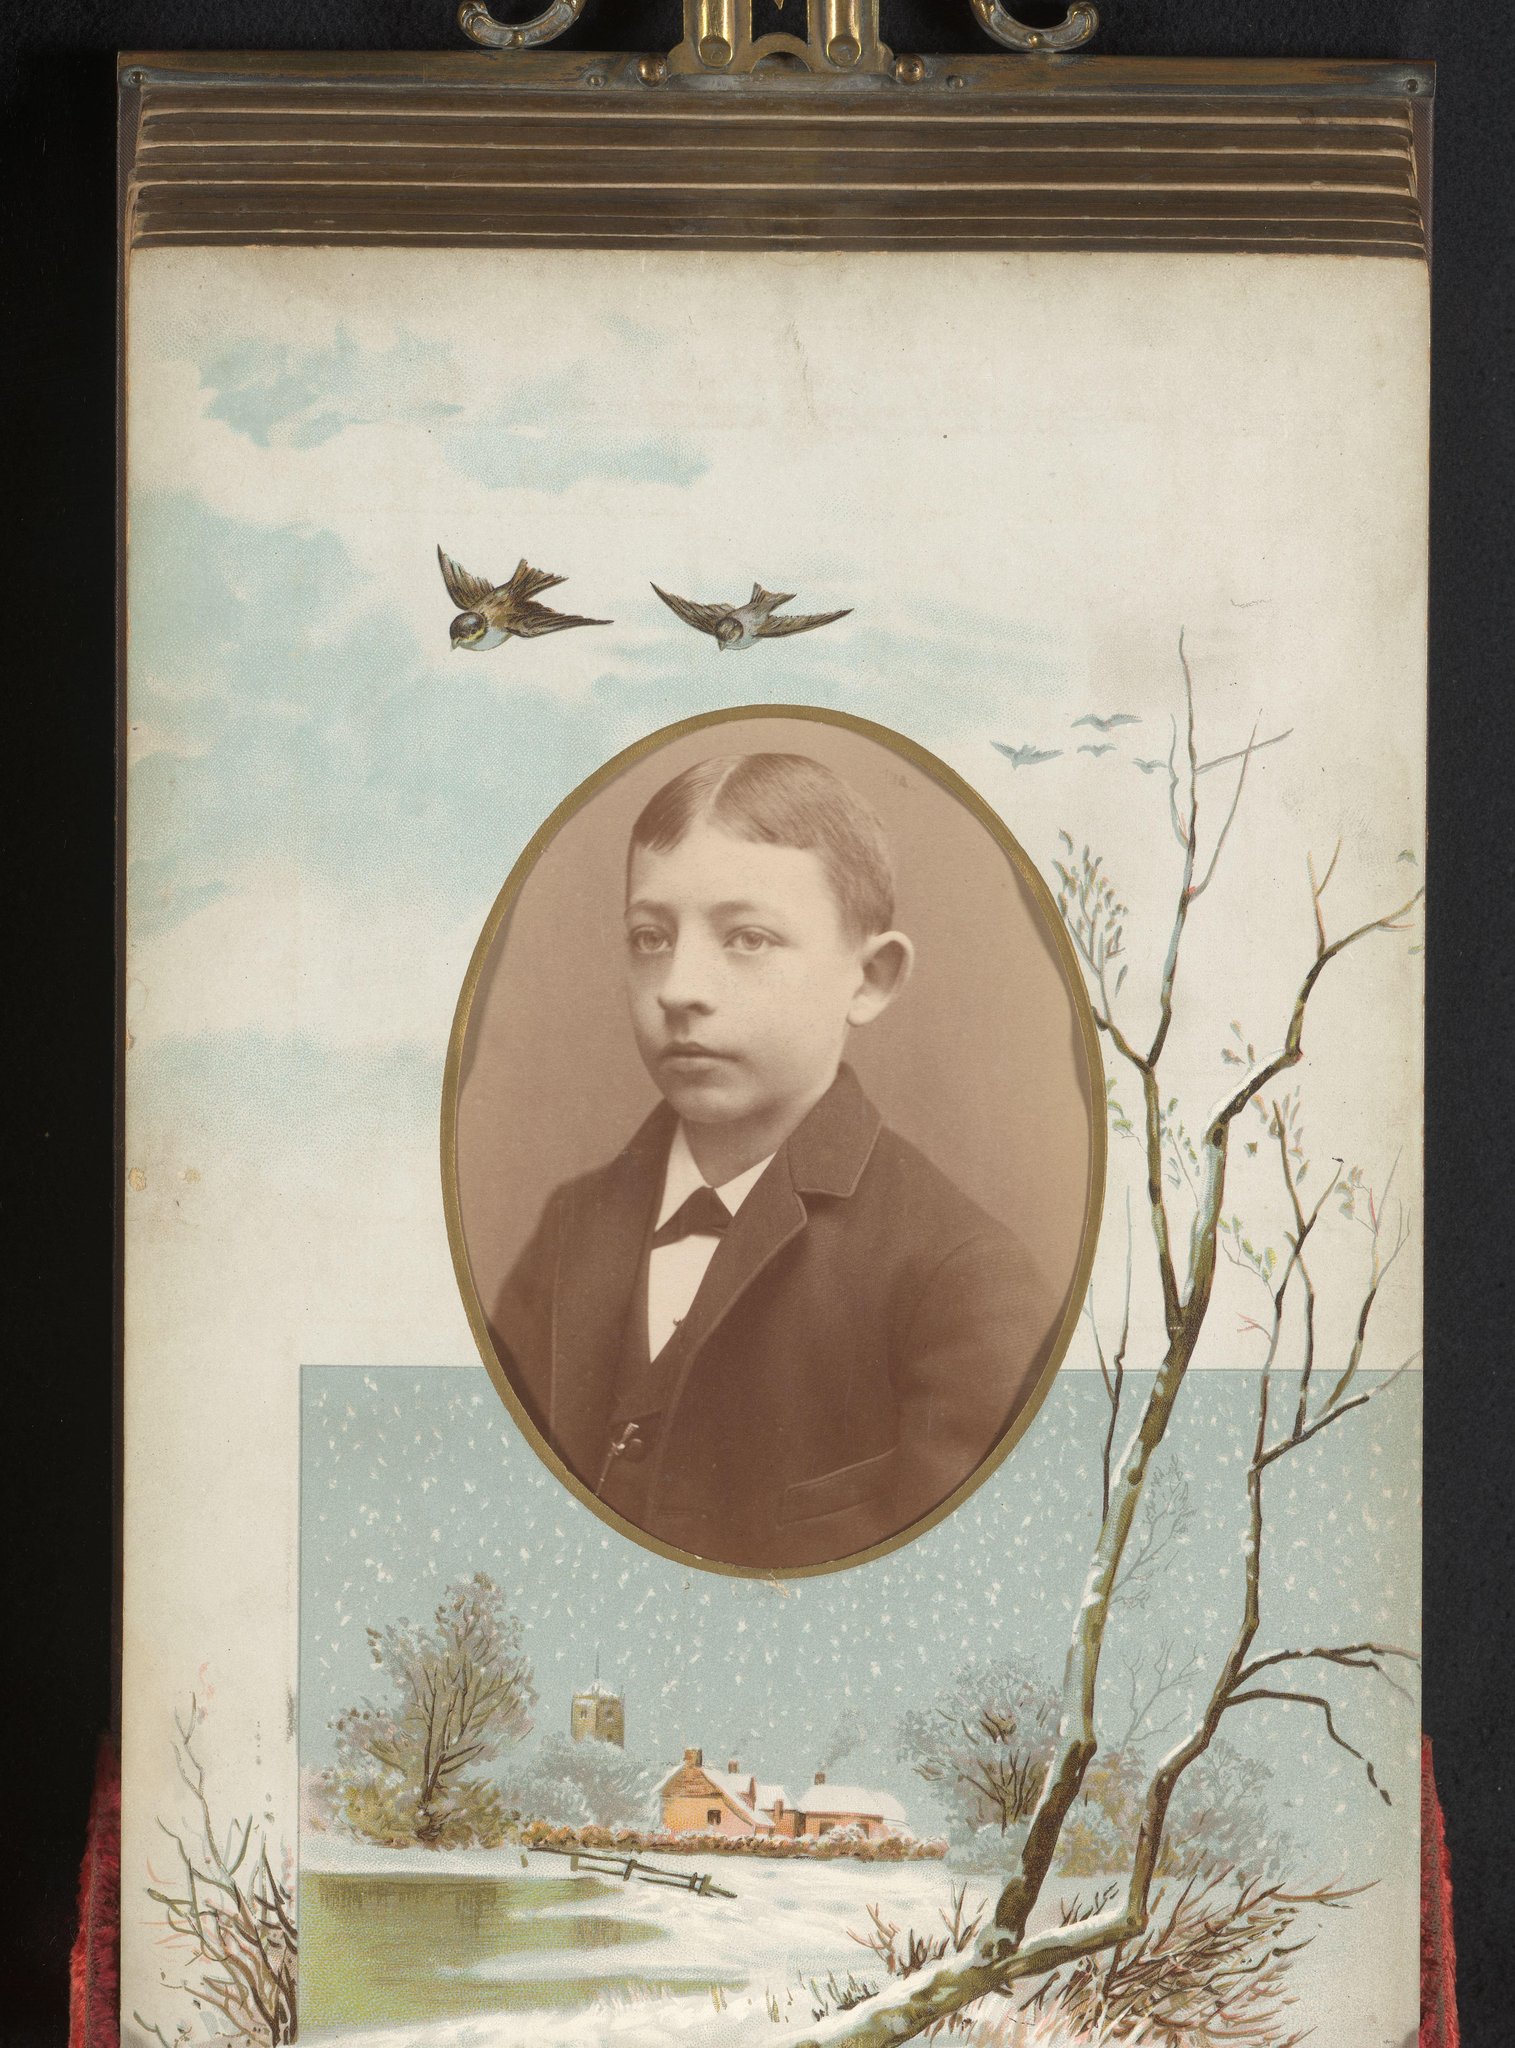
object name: album leaf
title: Portret van een jongen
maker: august roesler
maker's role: fotograaf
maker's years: 1837-1896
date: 1860-1896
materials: cardboard, photographic support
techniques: albumen print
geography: stockholm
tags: boy (child between toddler and youth), historical persons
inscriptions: inscription: ‘August Roesler/ Fotografi Atelier/ Stockholm/ Drottninggatan 23,/ Obs. Apotheket Morian./ Plåten förvaras för efterbeställning.’